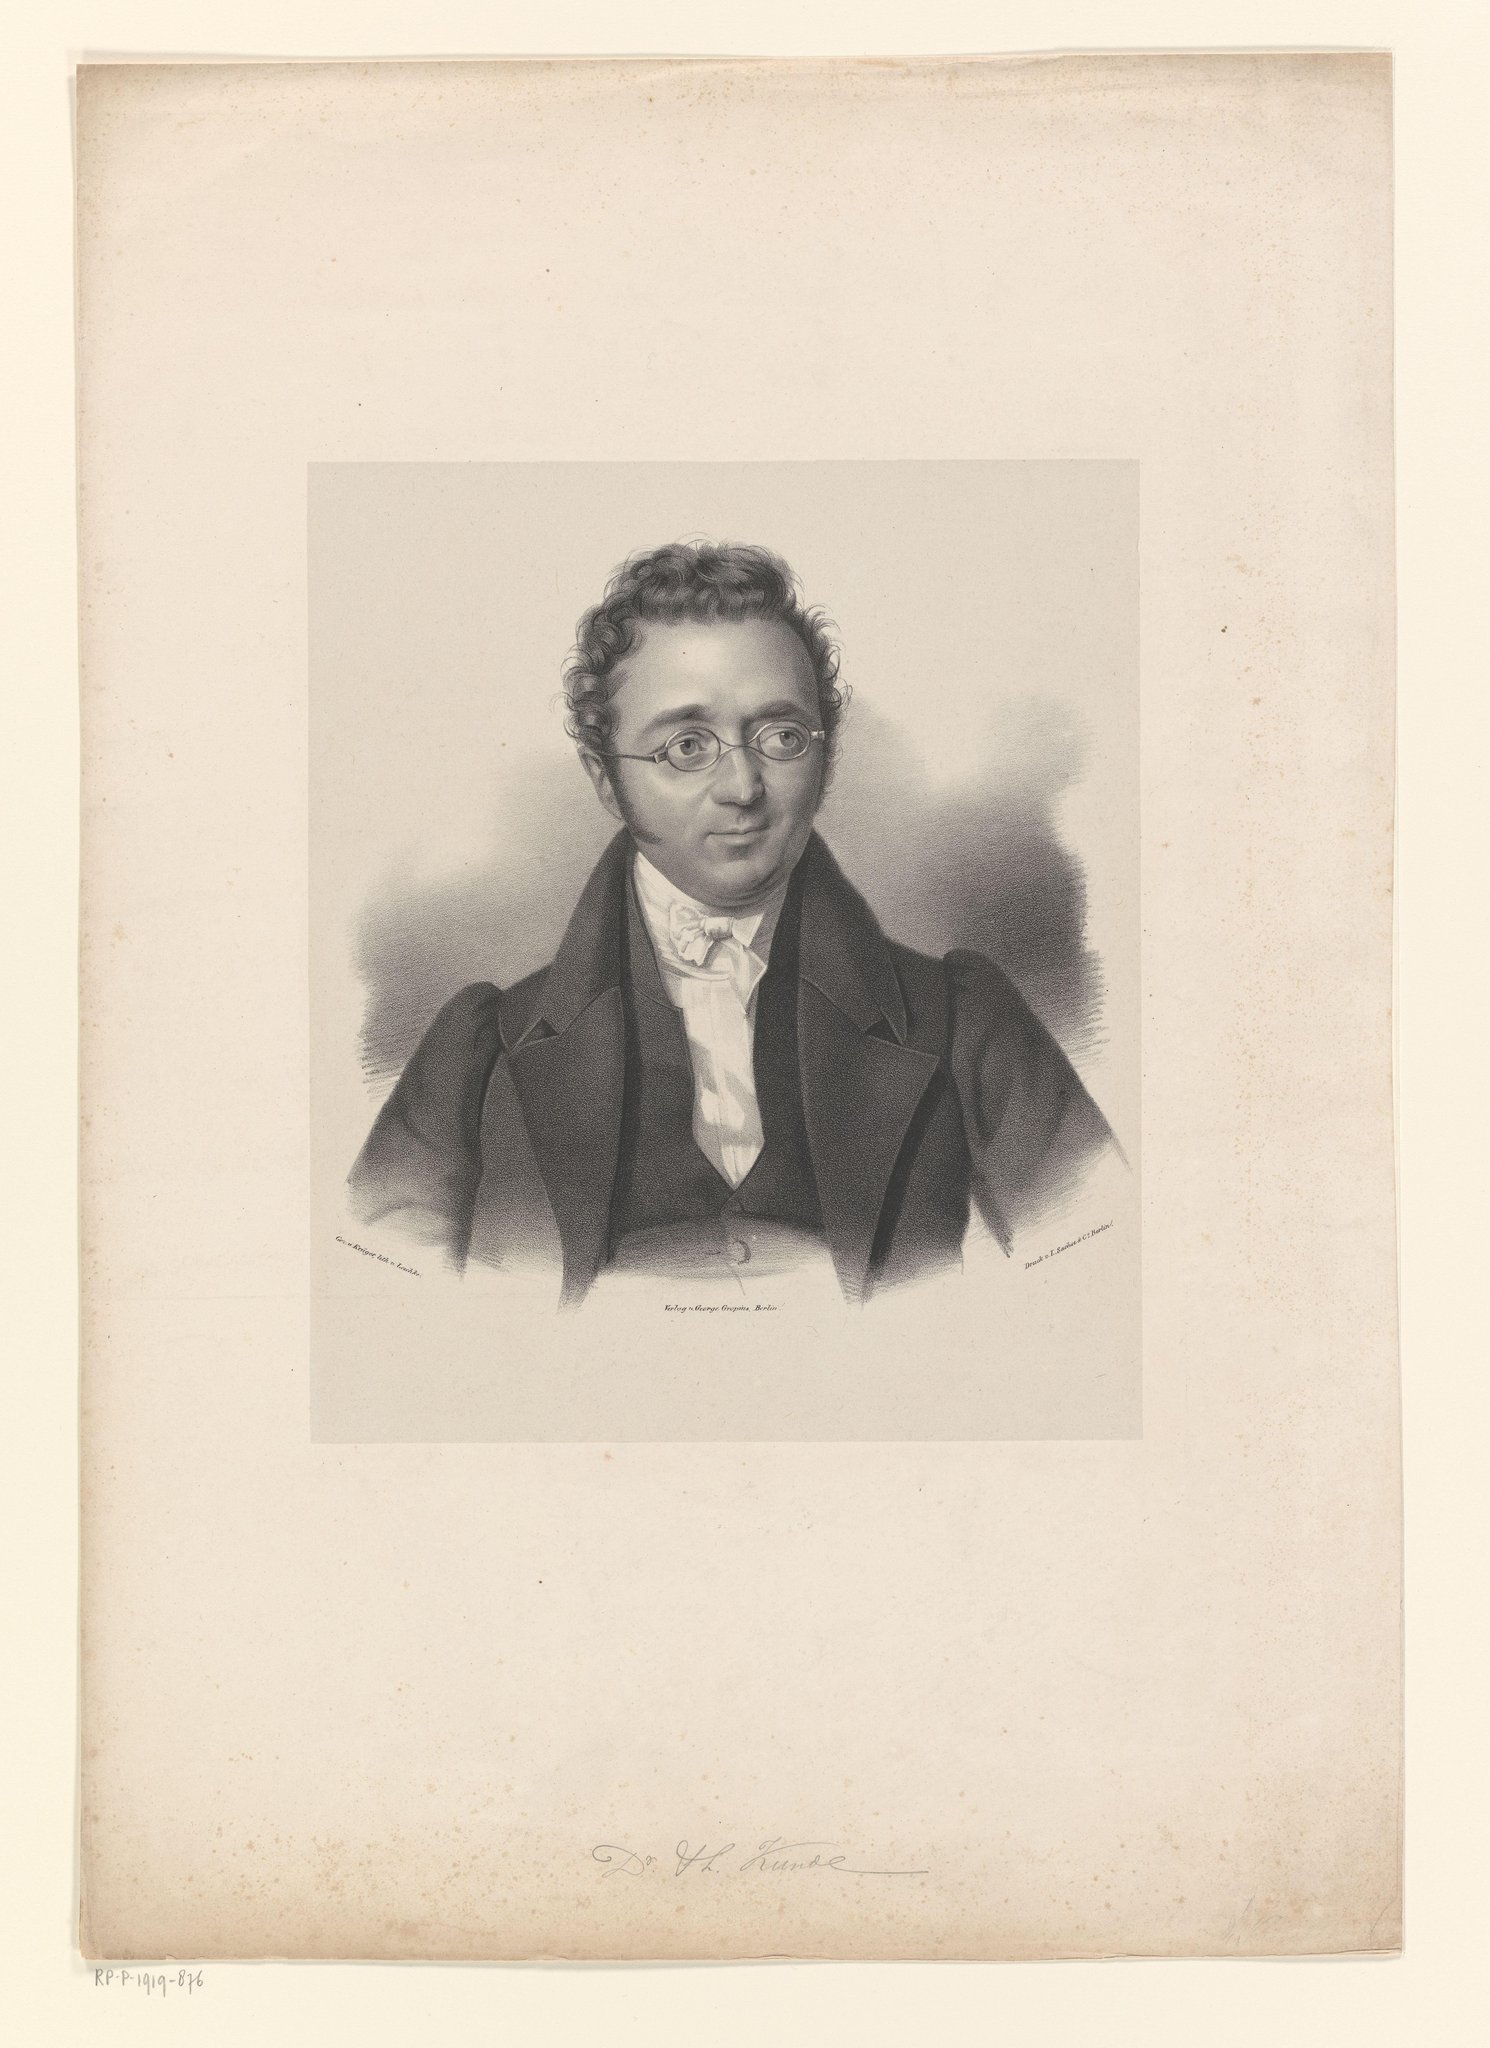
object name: print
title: Portret van een onbekende man, mogelijk Kunde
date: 1820-1875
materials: paper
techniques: lithograph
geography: berlin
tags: eyeglasses, spectacles, adult man, historical persons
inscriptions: check stamp: Lugt 4221, collector's mark: Lugt 2228